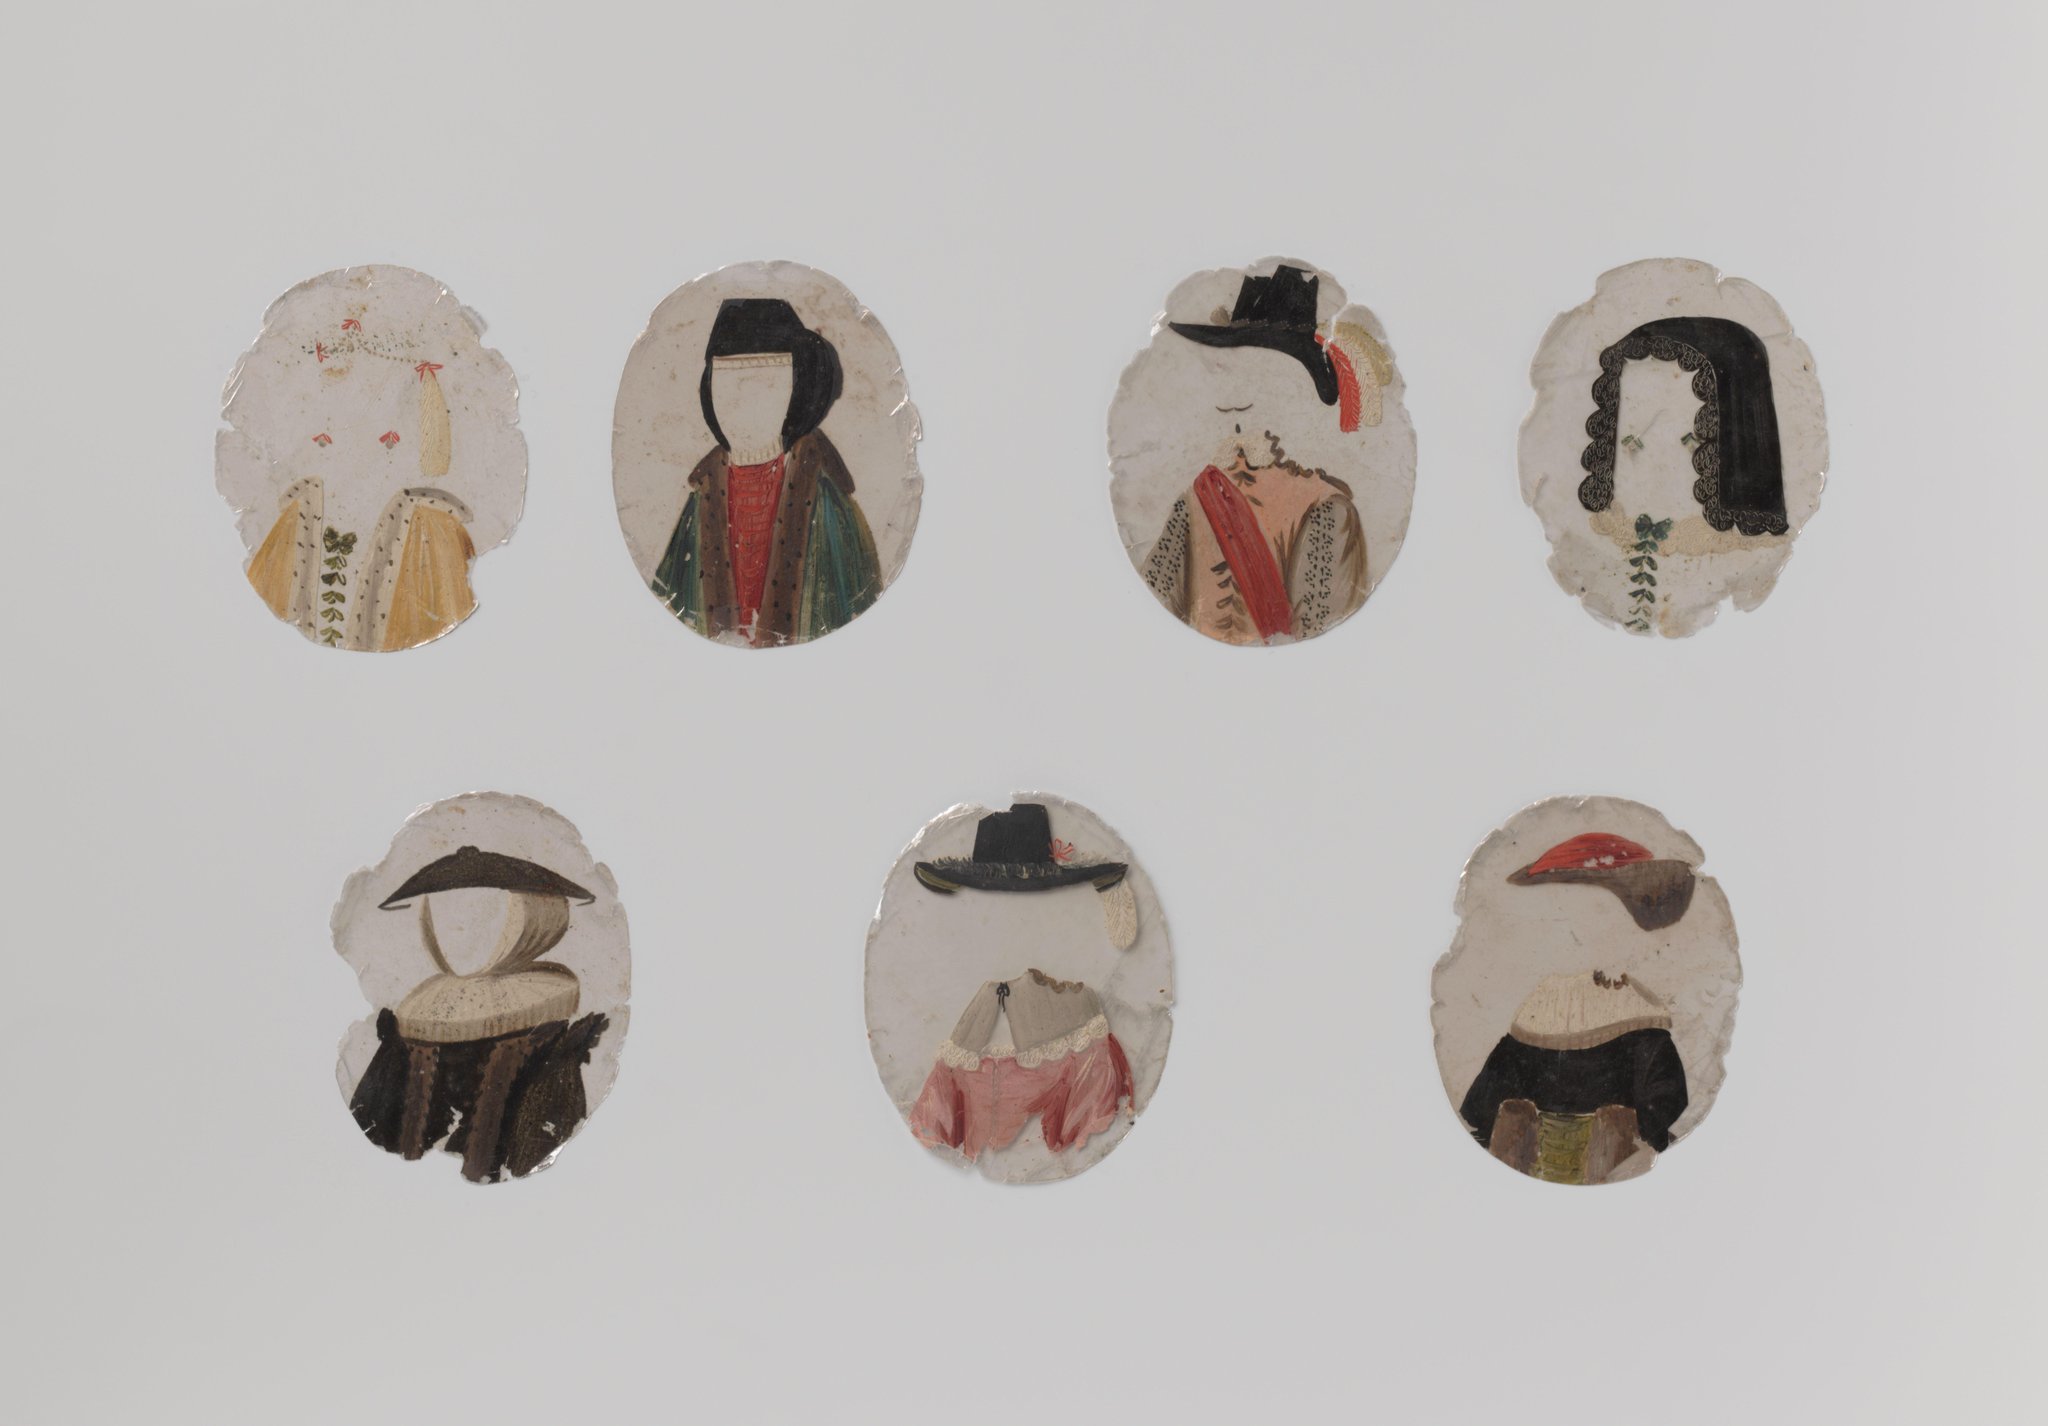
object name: game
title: Dertien transparantjes beschilderd met verschillende kostuums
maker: Anonymous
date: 1642-1652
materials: paint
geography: northern netherlands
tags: louise henriëtte (prinses van oranje), henriëtte catharina (prinses van oranje), the hague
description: Dertien transparantjes van mica beschilderd met verschillende kostuums. De verkledingen vertonen bijvoorbeeld huik met berthe-kraag, als vorstin met paarlenkroontje en hermelijnen schoudermantel, als stadsdame met bontomrande vlieger, hoofddoek en zwarte baret, als man met pluimhoed, sjerp, snor en sikje etc. Het portret stelt mogelijk een vrouwelijk lid van het huis Oranje Nassau voor: Louise Henriette of Henriette Catharina, dochters van Frederik Hendrik en Amalia van Solms.